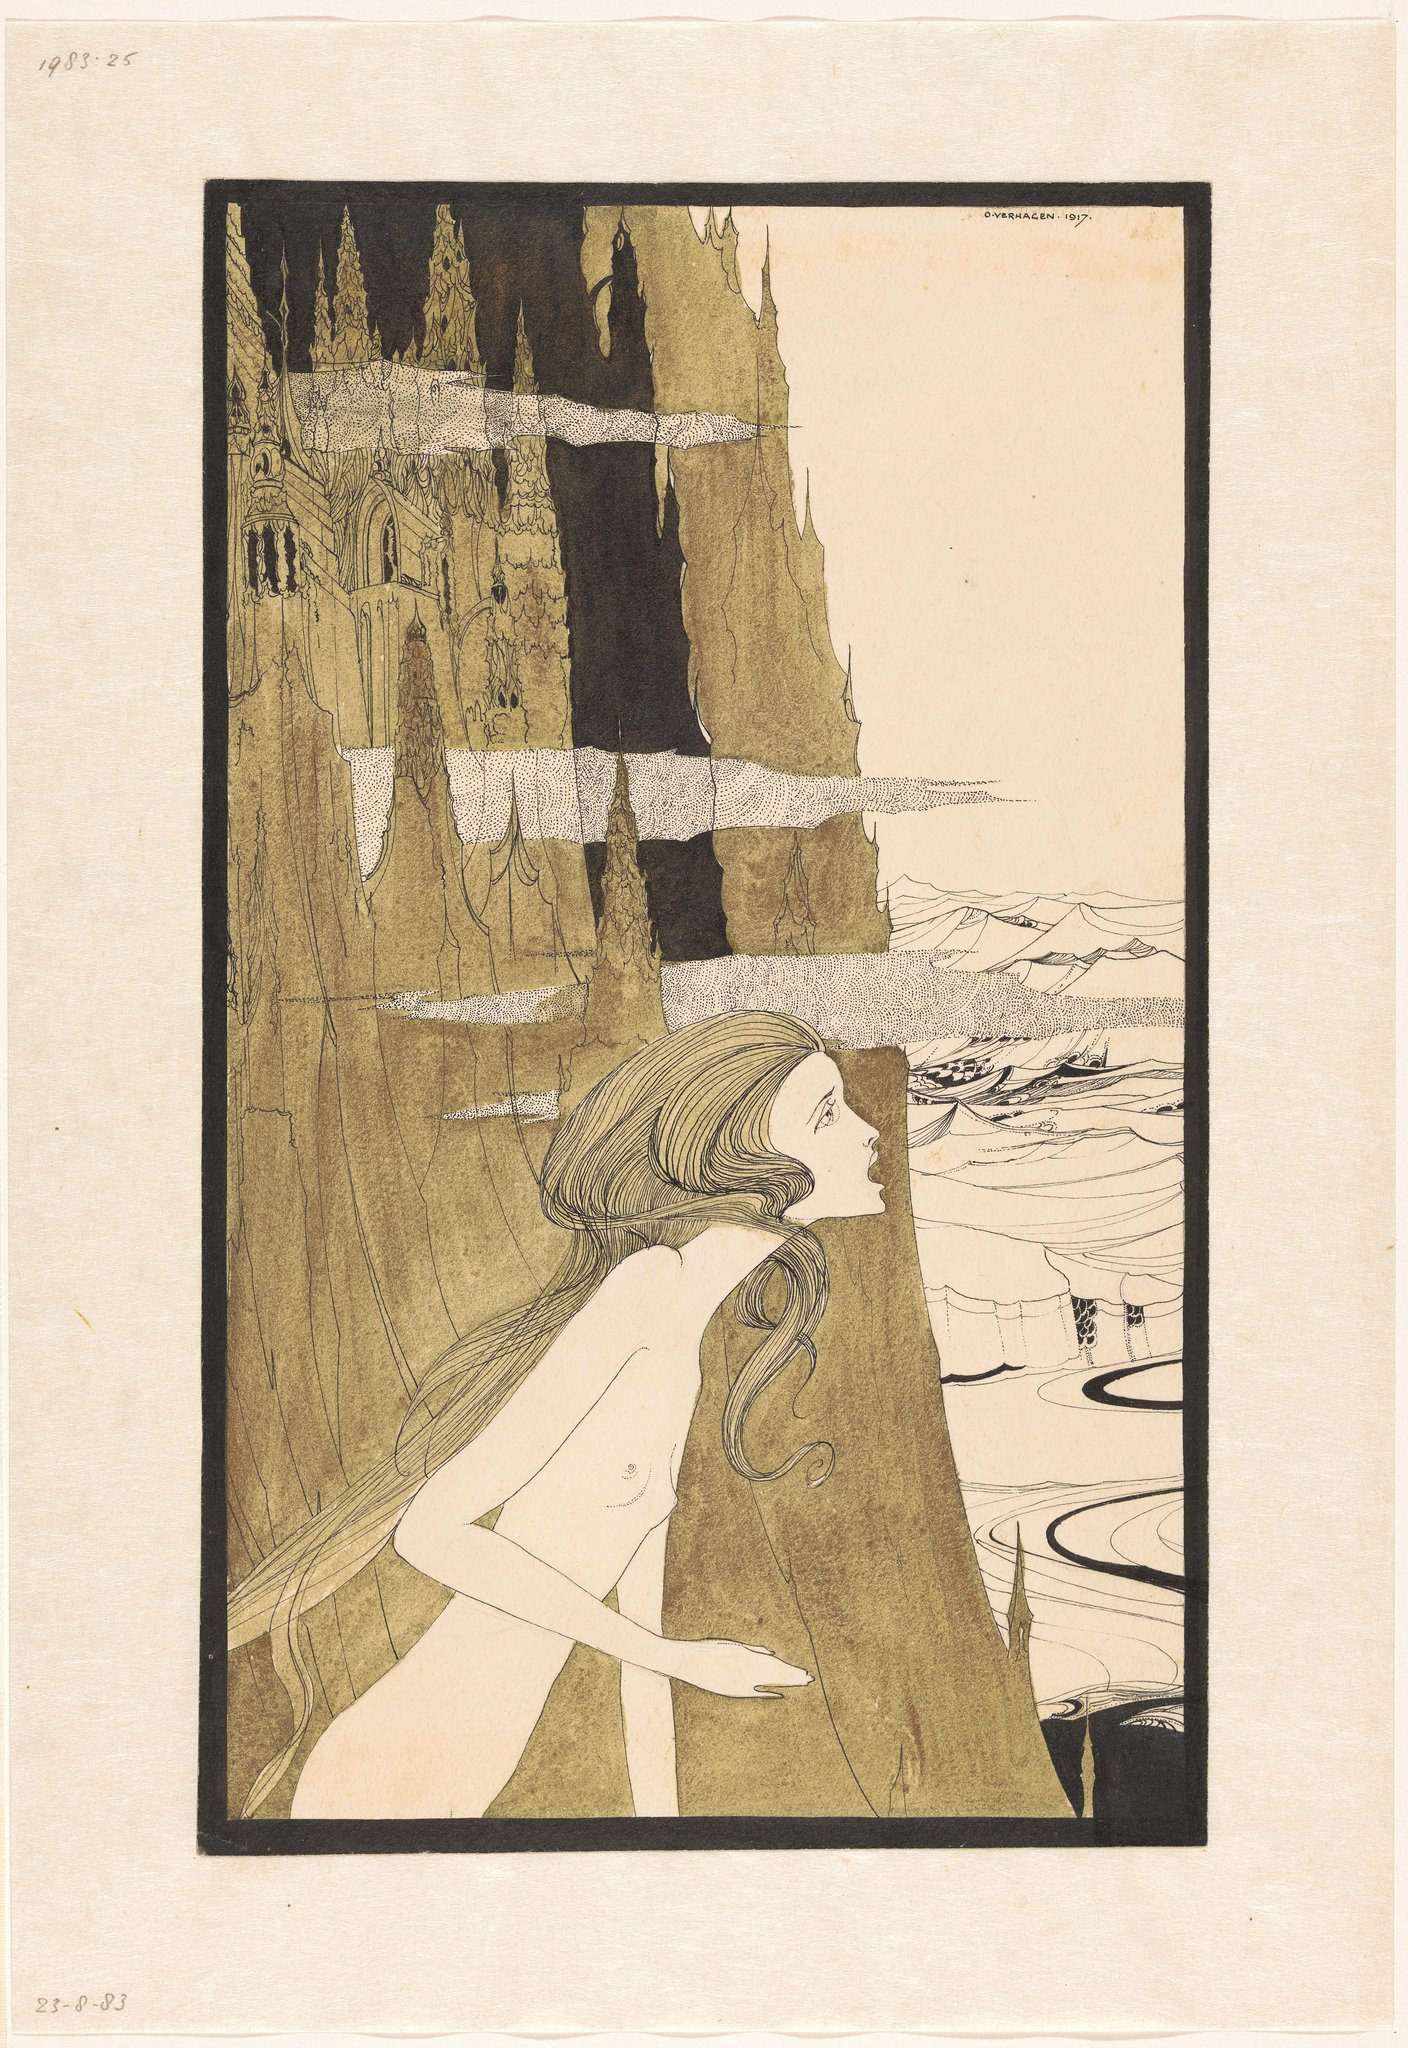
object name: boekillustratie ontwerp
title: Roepende vrouw voor rotsen met een kasteel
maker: otto verhagen (i)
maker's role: draughtsman, print maker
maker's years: 1885-1951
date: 1917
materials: paint, ink, paper, watercolor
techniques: brush, pen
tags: (couperus, psyche) specific works of literature (with author, title), (building) sand-castle, adult woman (+ sideview, profile)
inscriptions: collector's mark: Lugt 2228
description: Ontwerp voor een boekillustratie voor 'Psyche' van Louis Couperus.